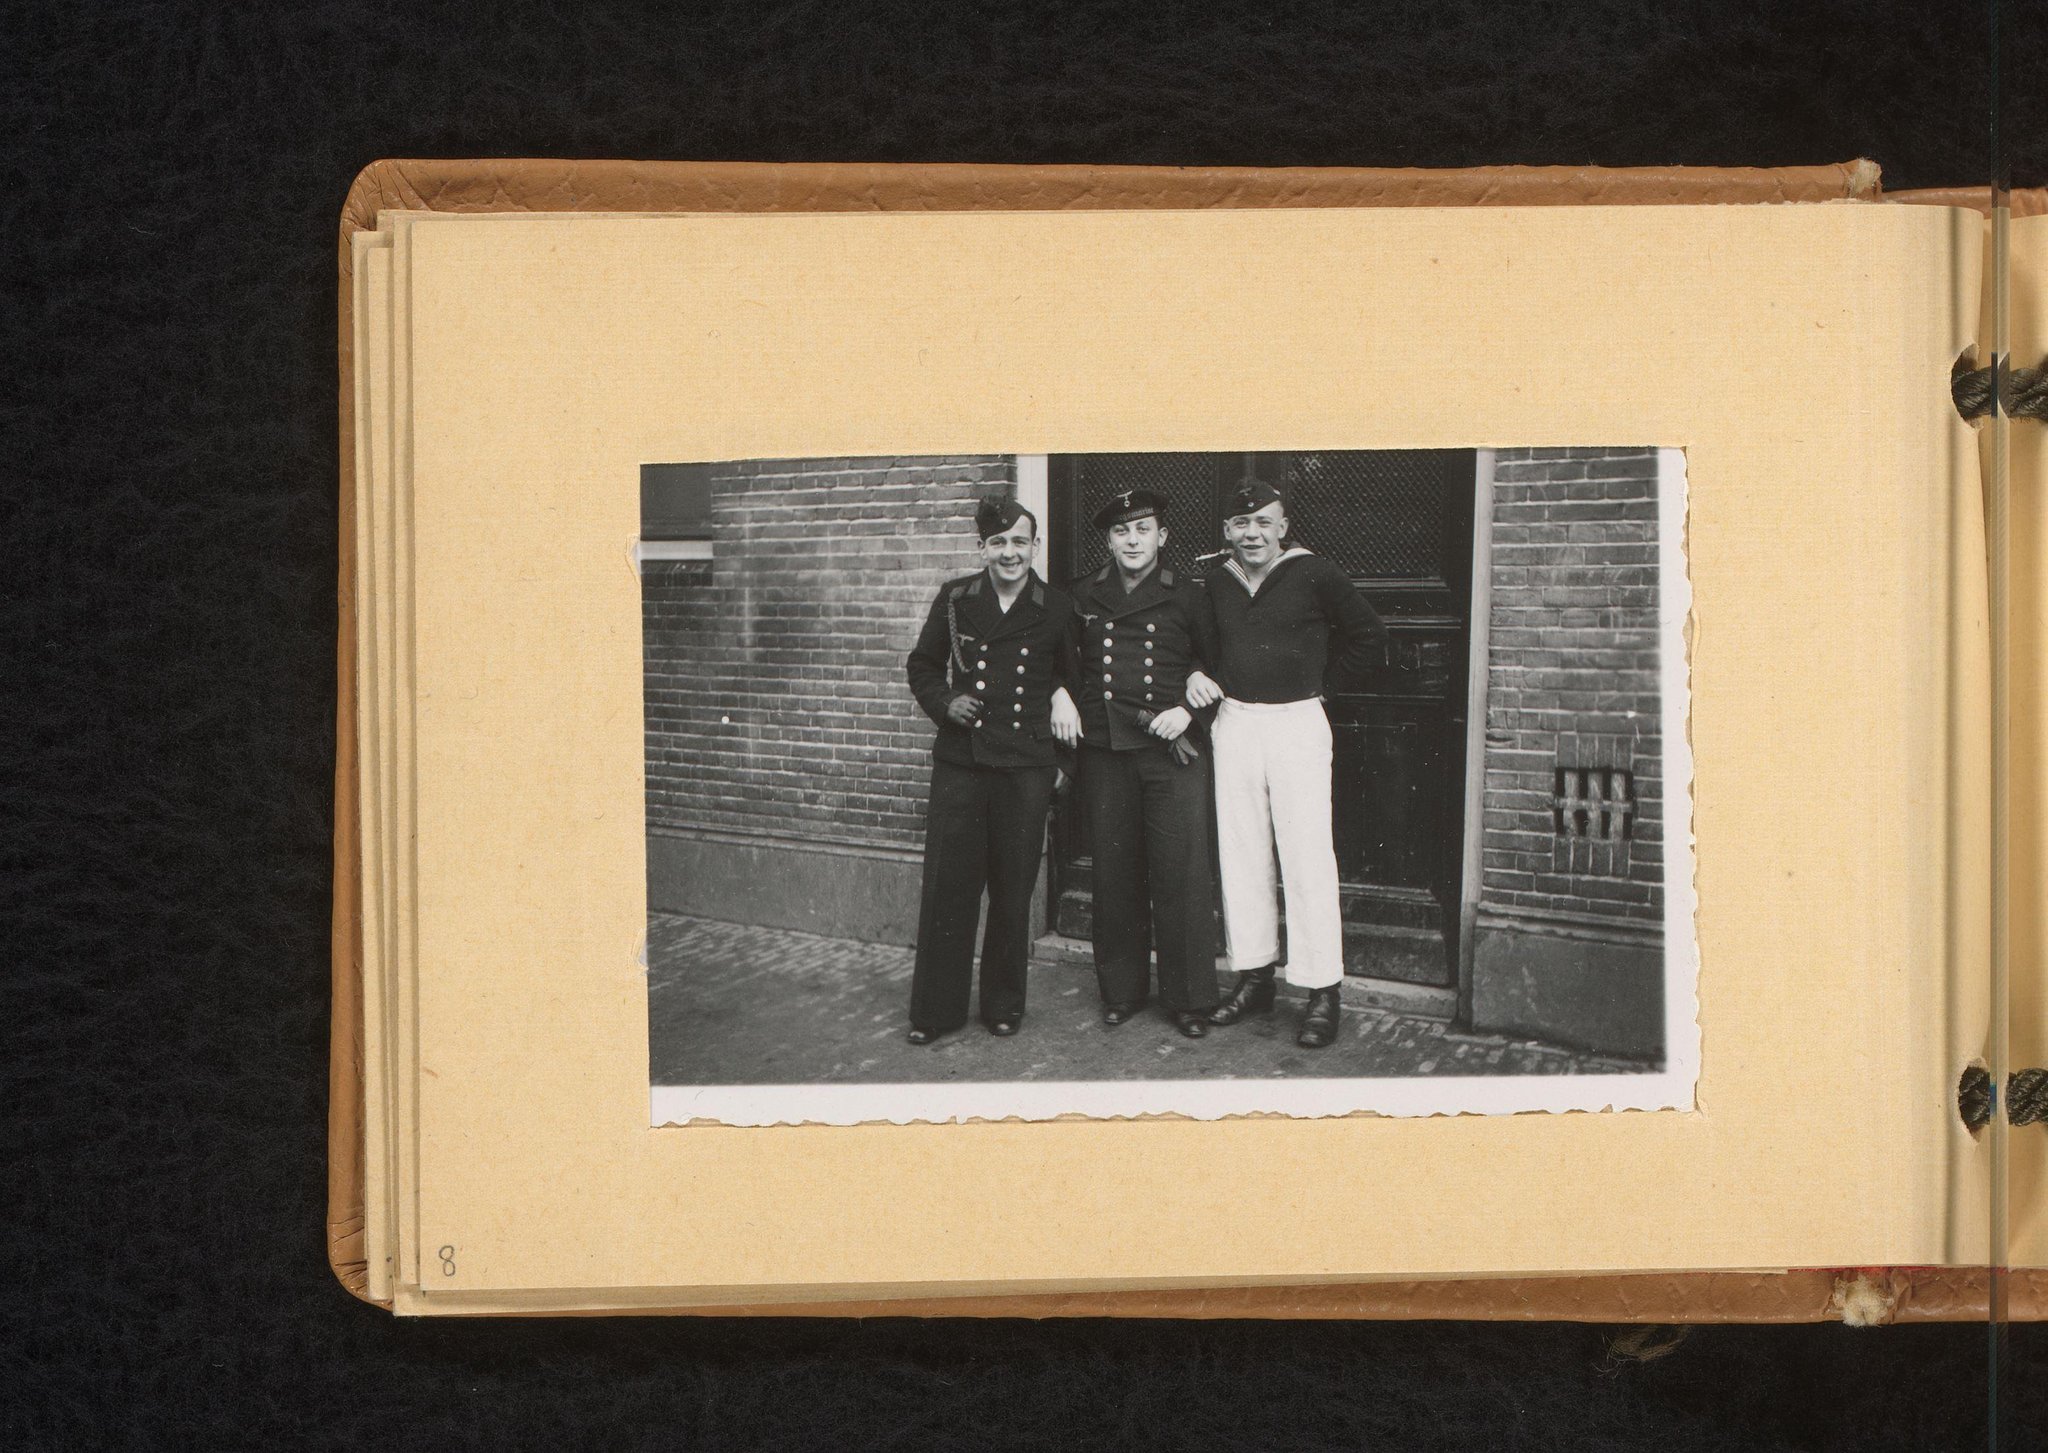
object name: album leaf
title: Staande militairen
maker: Anonymous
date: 1940-1943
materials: paper, photographic support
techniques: gelatin silver print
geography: netherlands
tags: the company, the unit, the troop ~ military service, shelter ~ military service, occupation ~ war, netherlands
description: Albumblad met een foto van drie militairen van de Kriegsmarine staande voor een gebouw. Onderdeel van een klein album van de Kriegsmarine in Nederland.